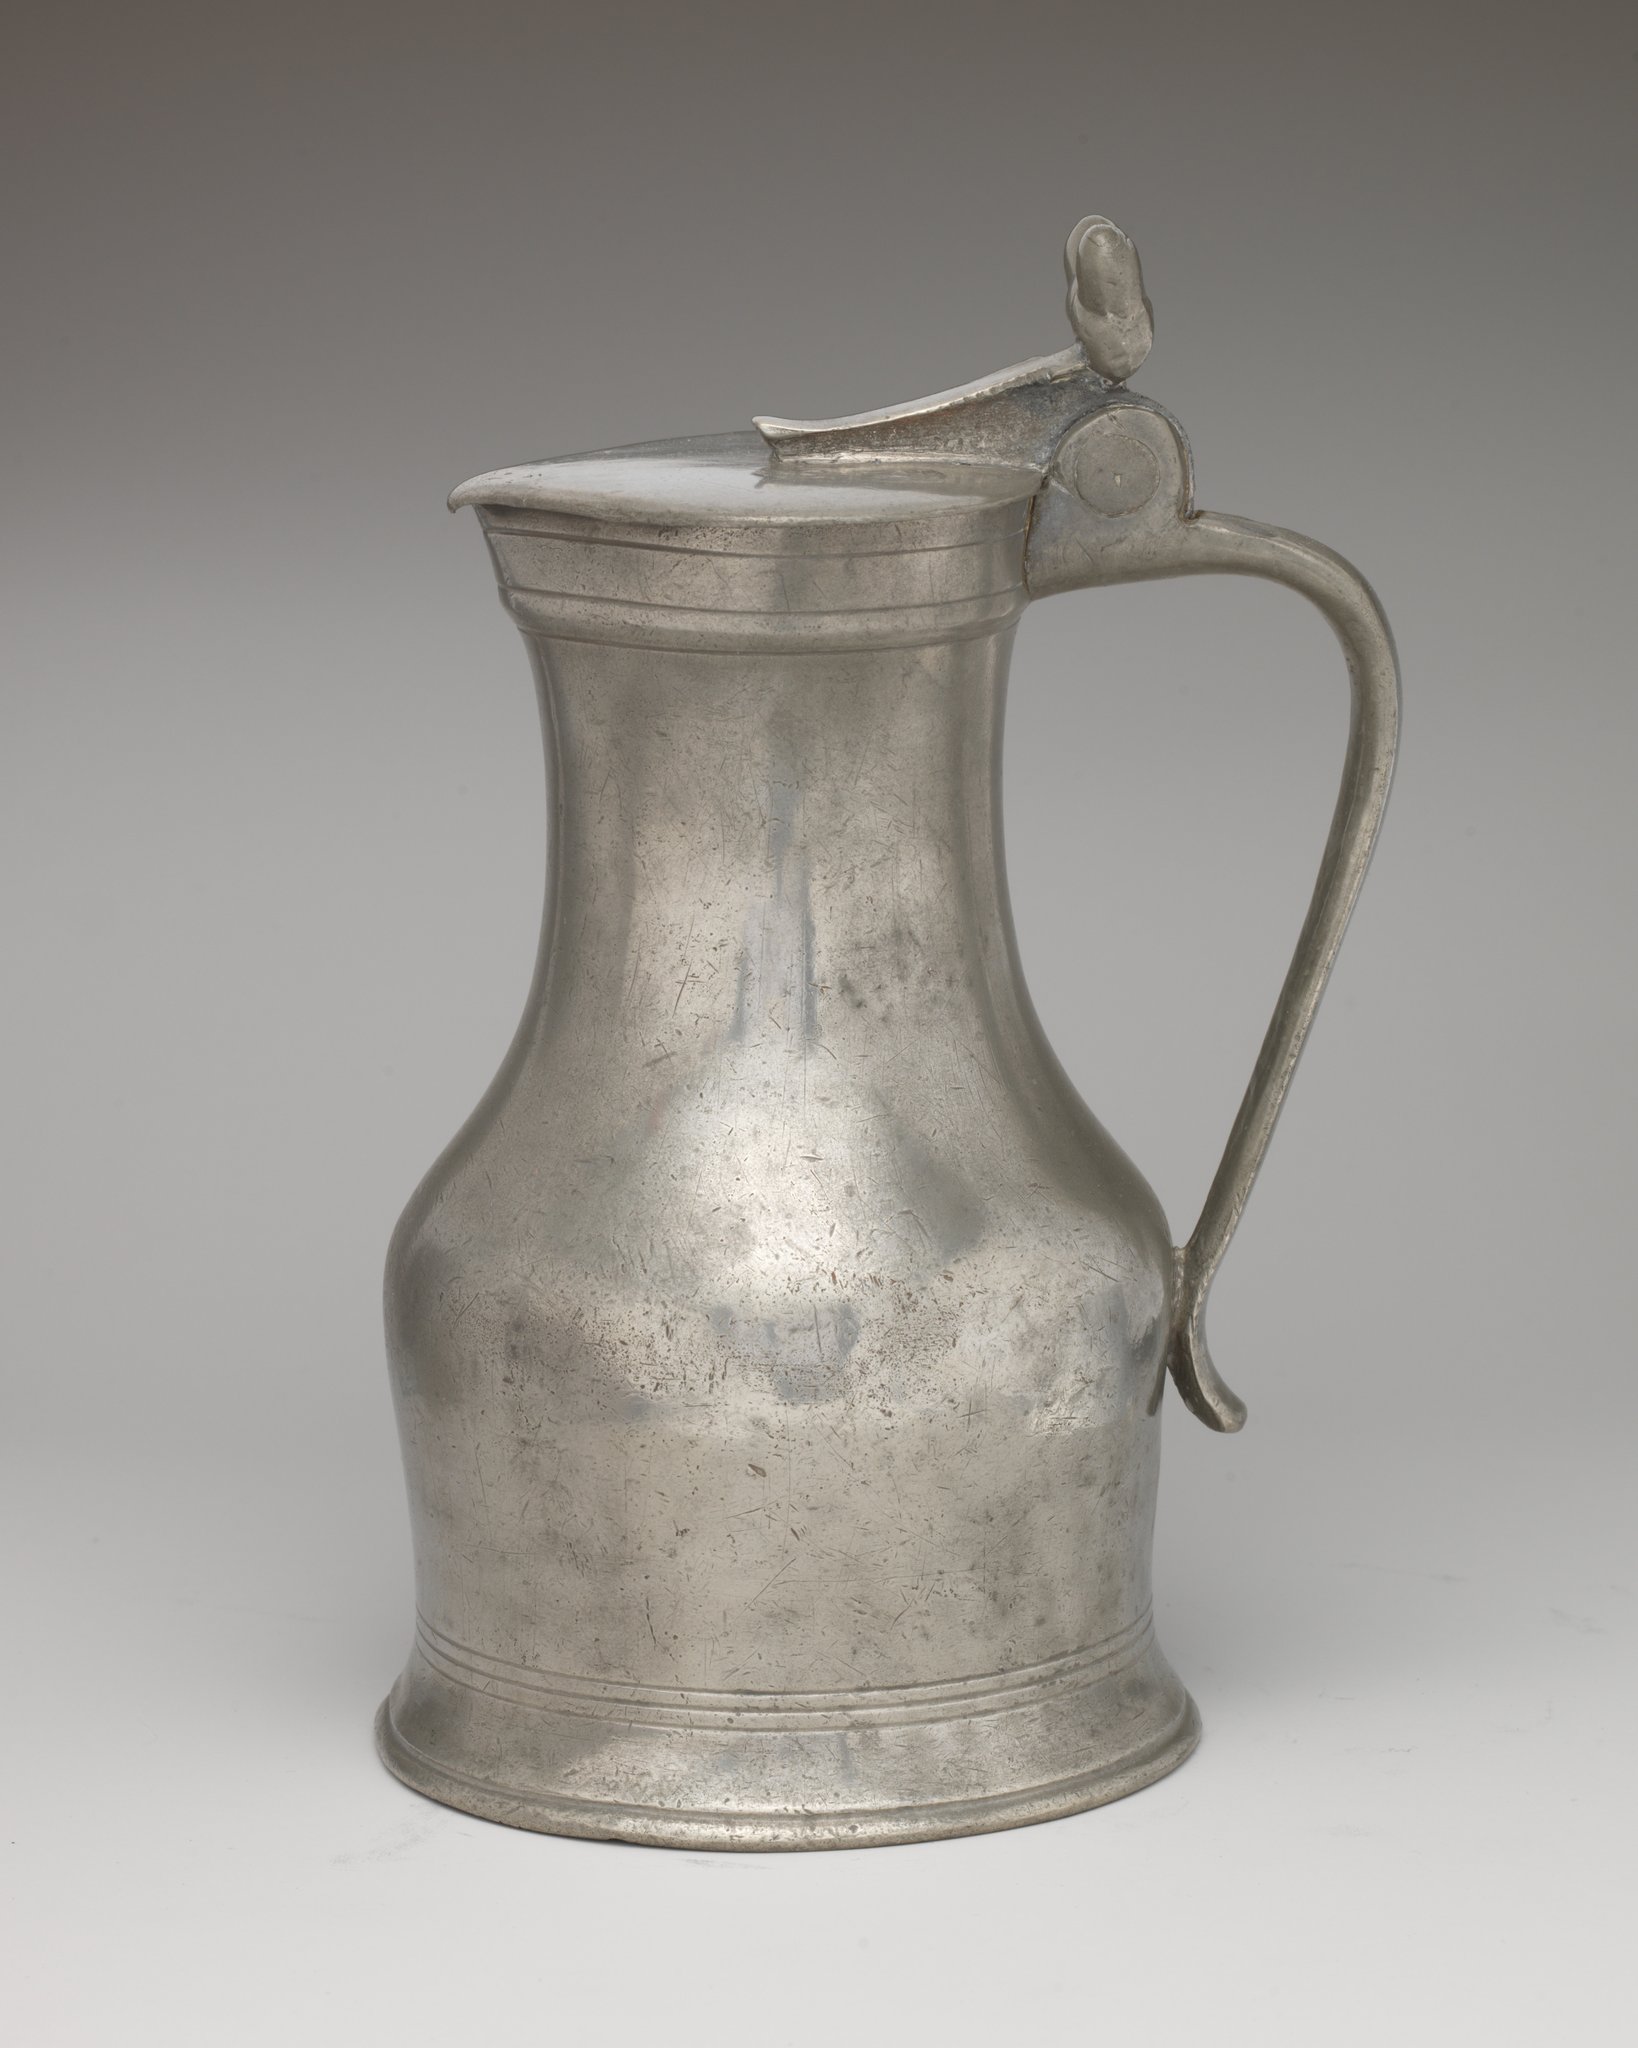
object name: measure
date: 1701-1800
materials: pewter